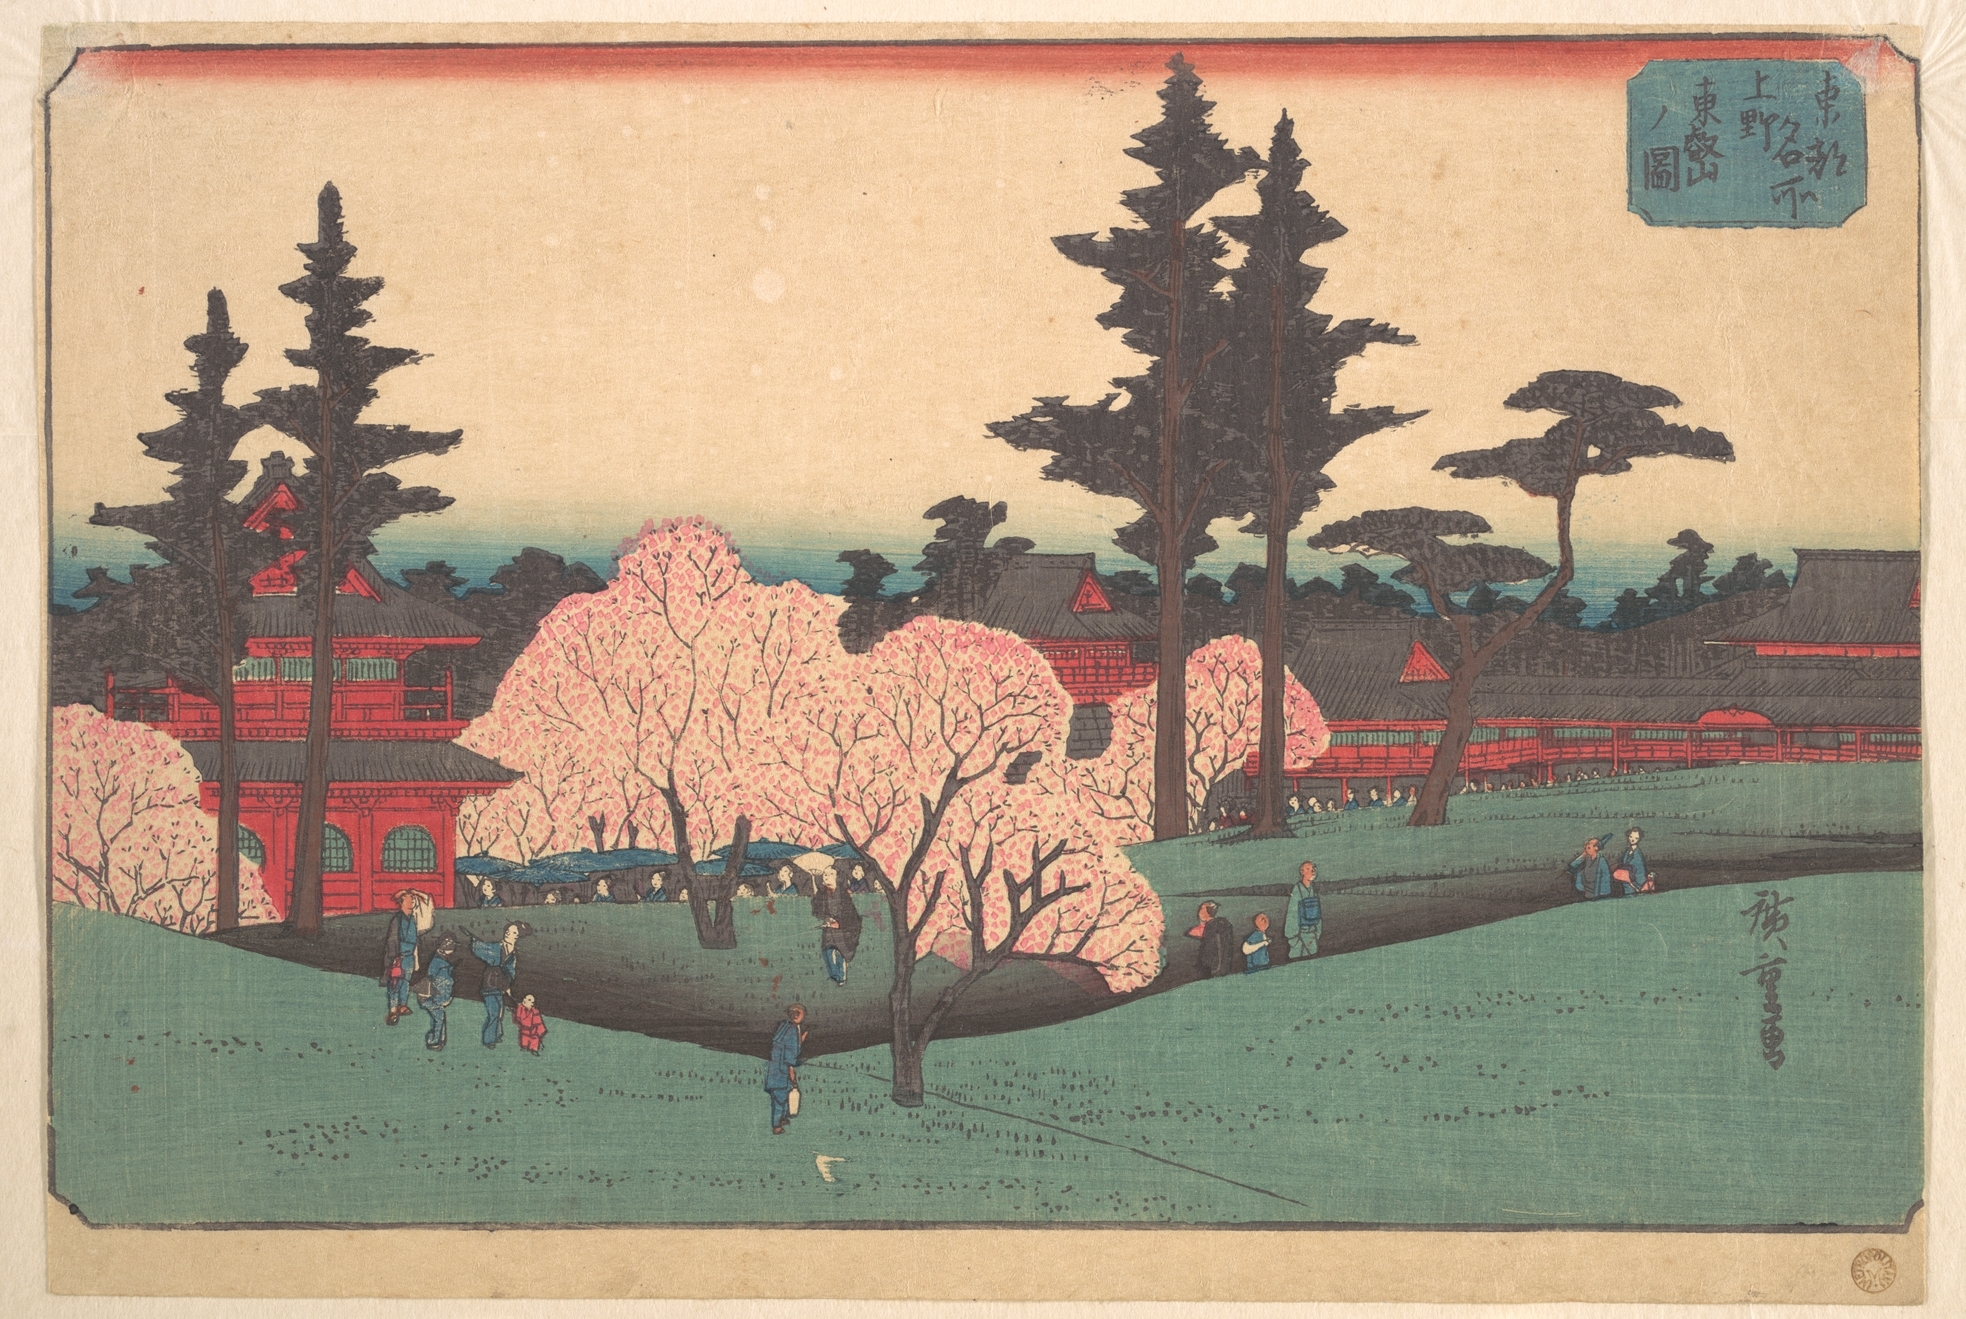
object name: print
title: Ueno Toezan no Zu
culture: japanese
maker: utagawa hiroshige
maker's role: artist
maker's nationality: japanese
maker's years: 1797-1858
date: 1835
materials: ink, paper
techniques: woodblock print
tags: human figures,houses,trees